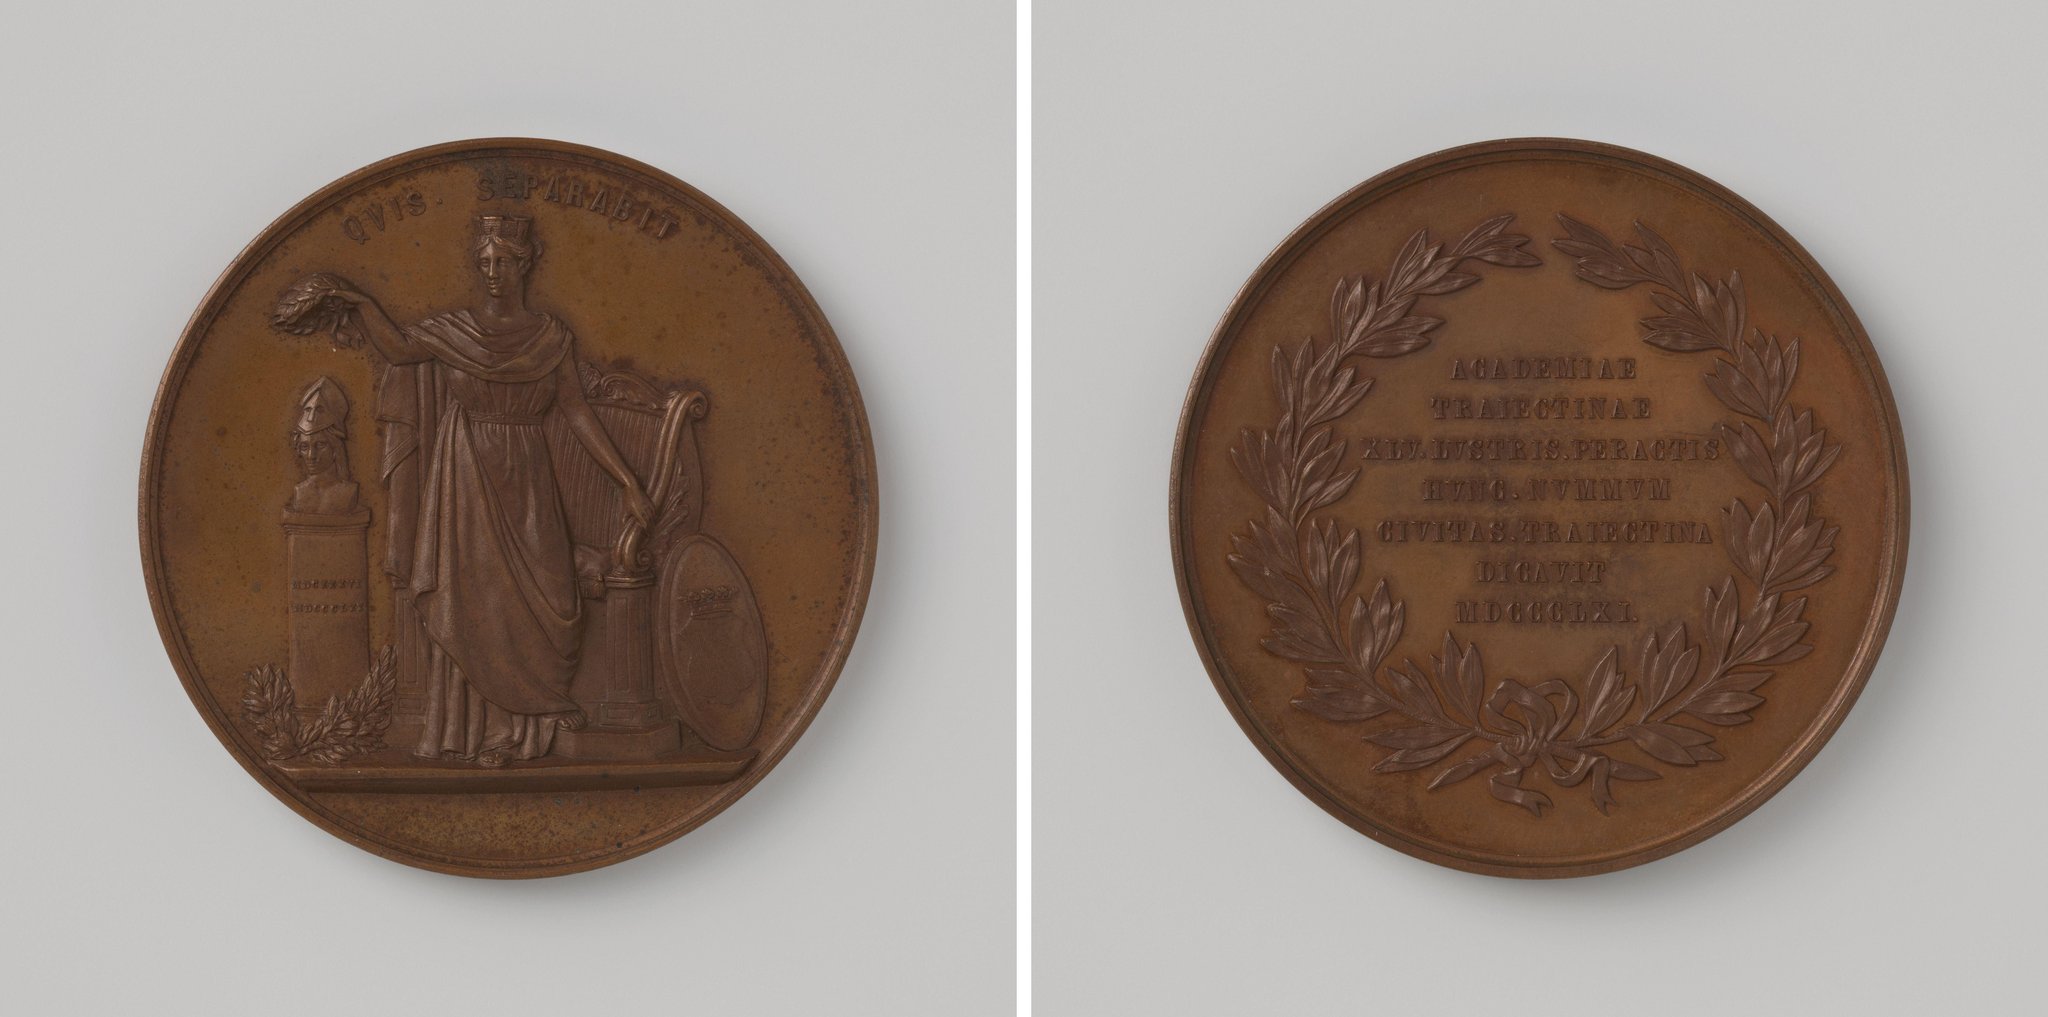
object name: history medal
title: Vijfenveertgste lustrum van de Universiteit van Utrecht 1861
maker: johan philip menger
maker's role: medailleur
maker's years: 1818-1895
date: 1861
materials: bronze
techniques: striking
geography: utrecht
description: Bronzen penning, op de voorzijde de stadsgodin van Utrecht, opgestaan uit haar zetel waartegen een schild met het wapen van de stad Utrecht, lauwert een borstbeeld van Minerva op zuil, met bovenaan omschrift, op de keerzijde zeven regels tekst tussen samengestrikte lauwertakken.